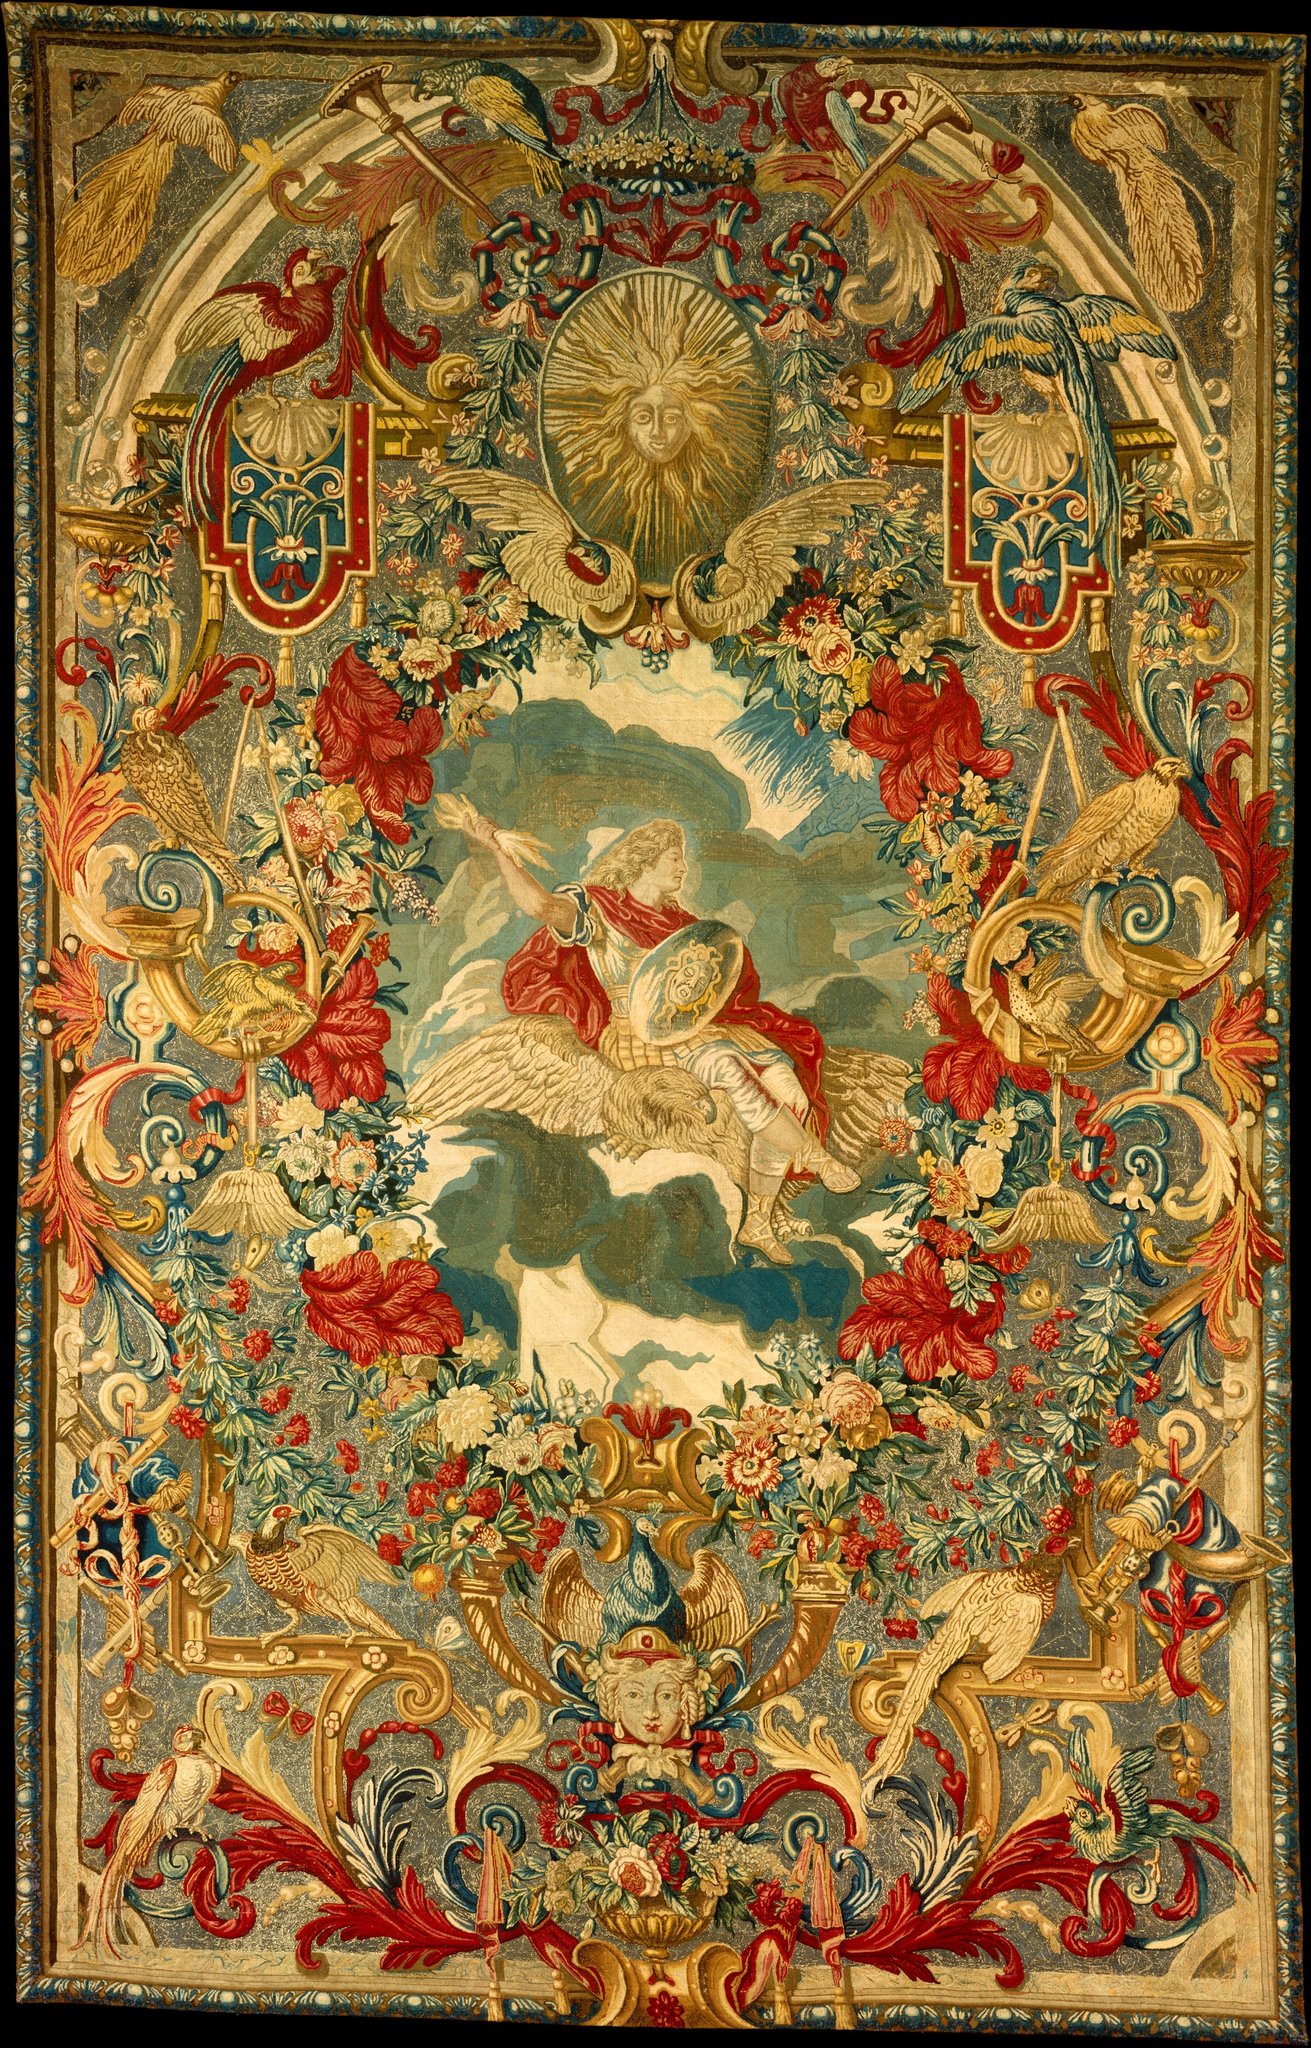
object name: hanging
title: Seasons and Elements (Air) (set of four)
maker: charles le brun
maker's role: artist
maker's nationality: french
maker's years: 1619-1690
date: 1683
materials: canvas, metal thread, silk, wool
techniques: embroidery, stitching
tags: birds,louis xiv,jupiter,parrots,sun,roses